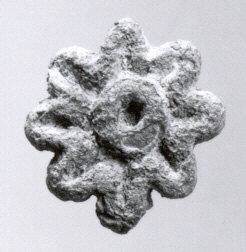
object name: stamp seal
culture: bactria-margiana archaeological complex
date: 2333-1668 BCE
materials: copper alloy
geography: bactria-margiana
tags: flowers